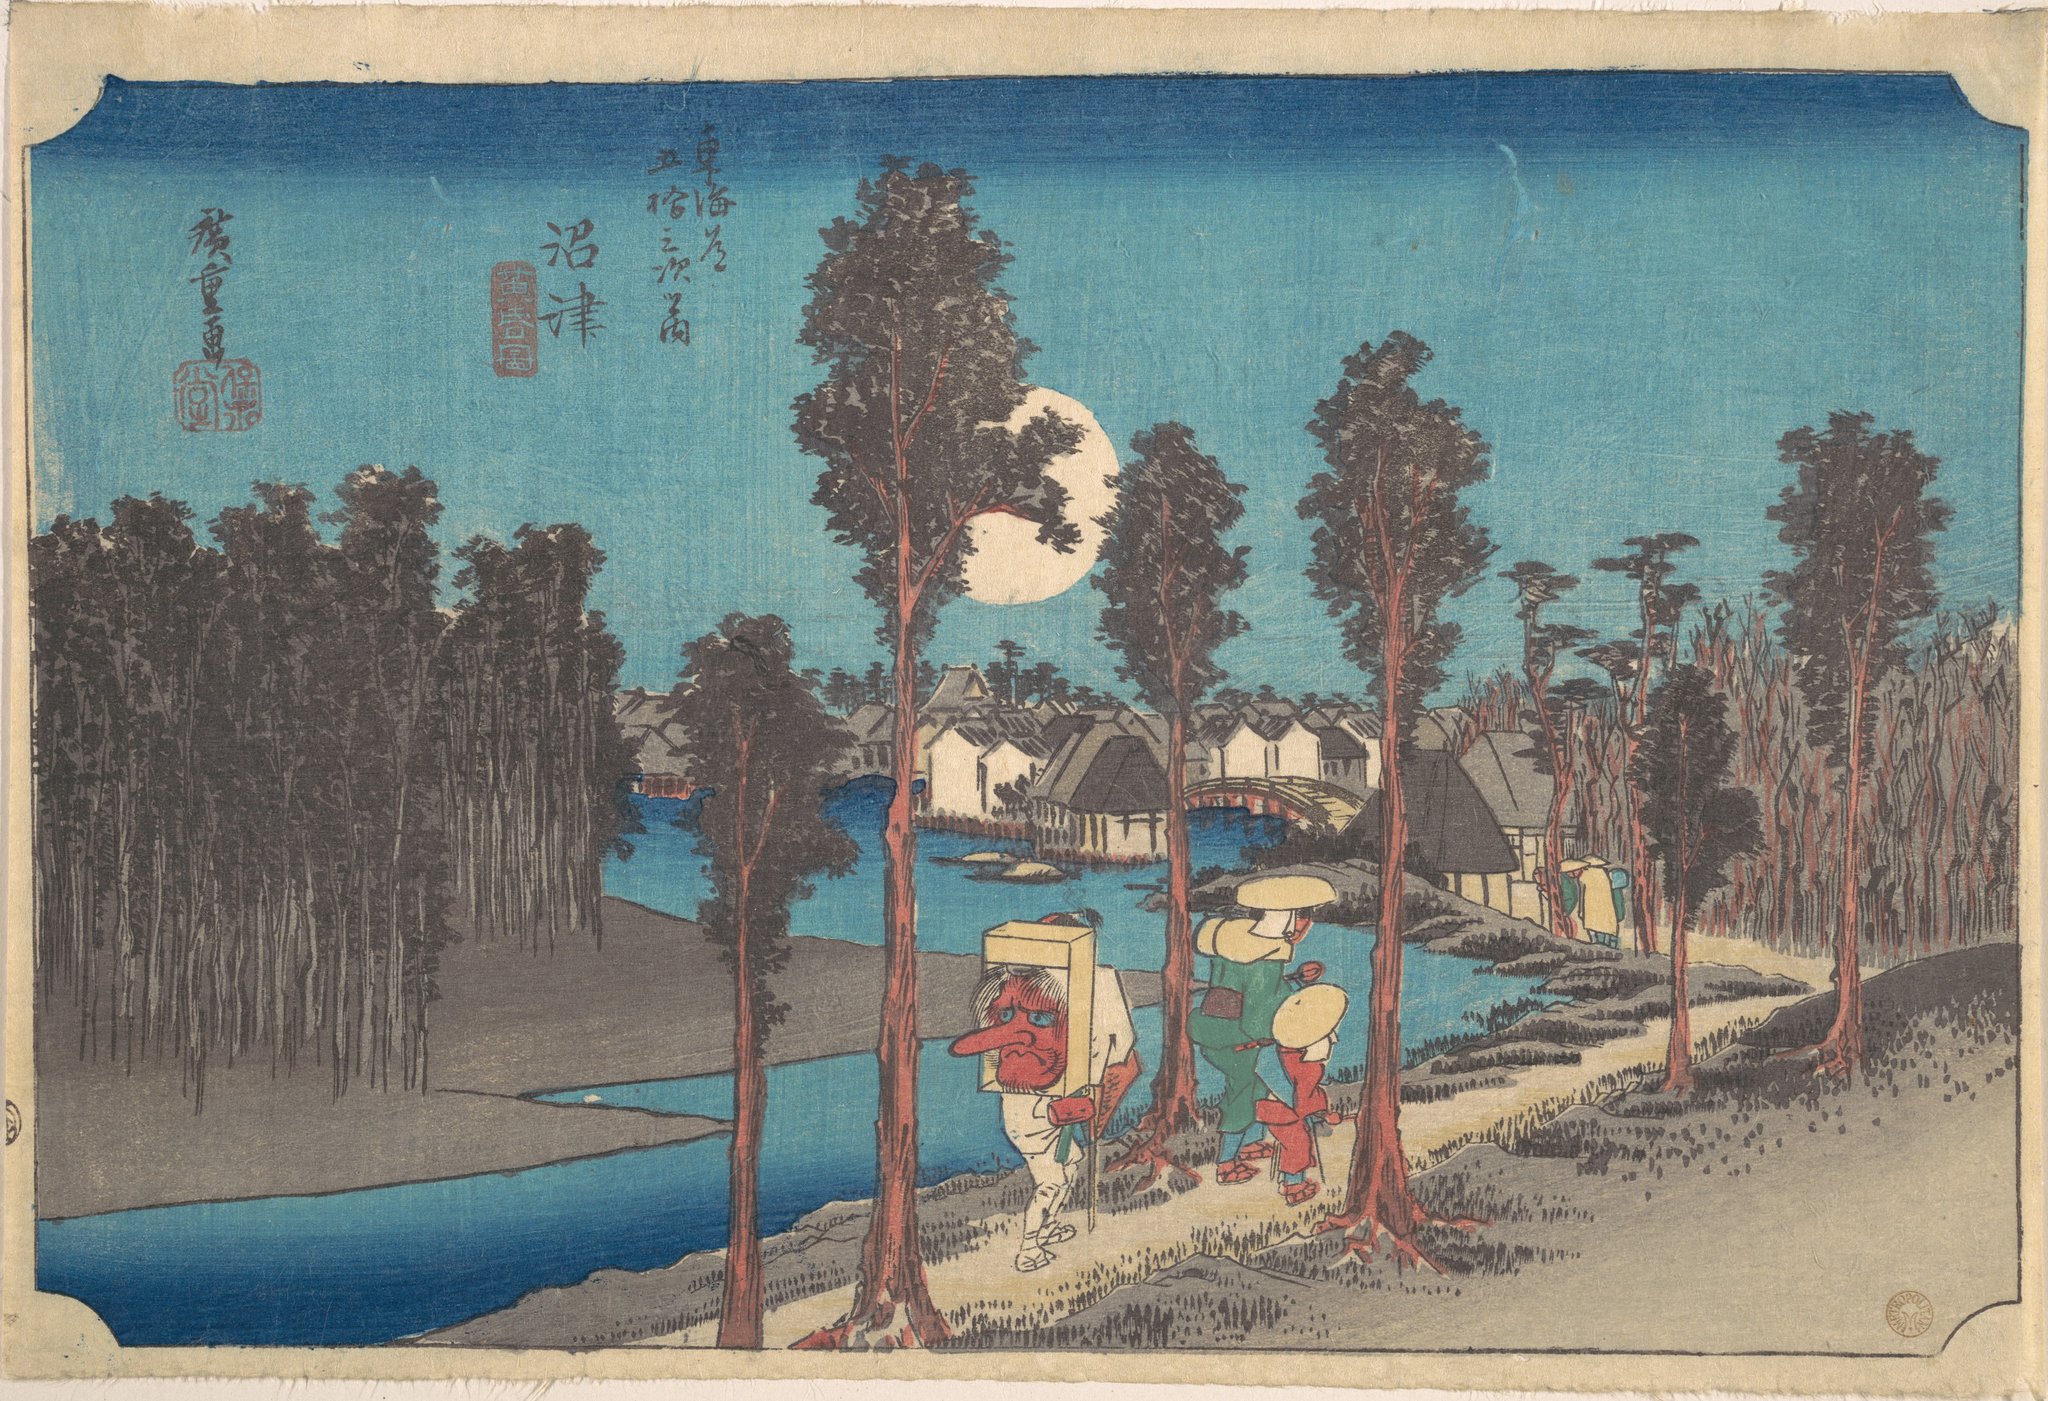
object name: print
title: Numazu Ki Kure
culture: japanese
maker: utagawa hiroshige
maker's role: artist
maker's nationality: japanese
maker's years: 1797-1858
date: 1834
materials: ink, paper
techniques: woodblock print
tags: human figures,trees